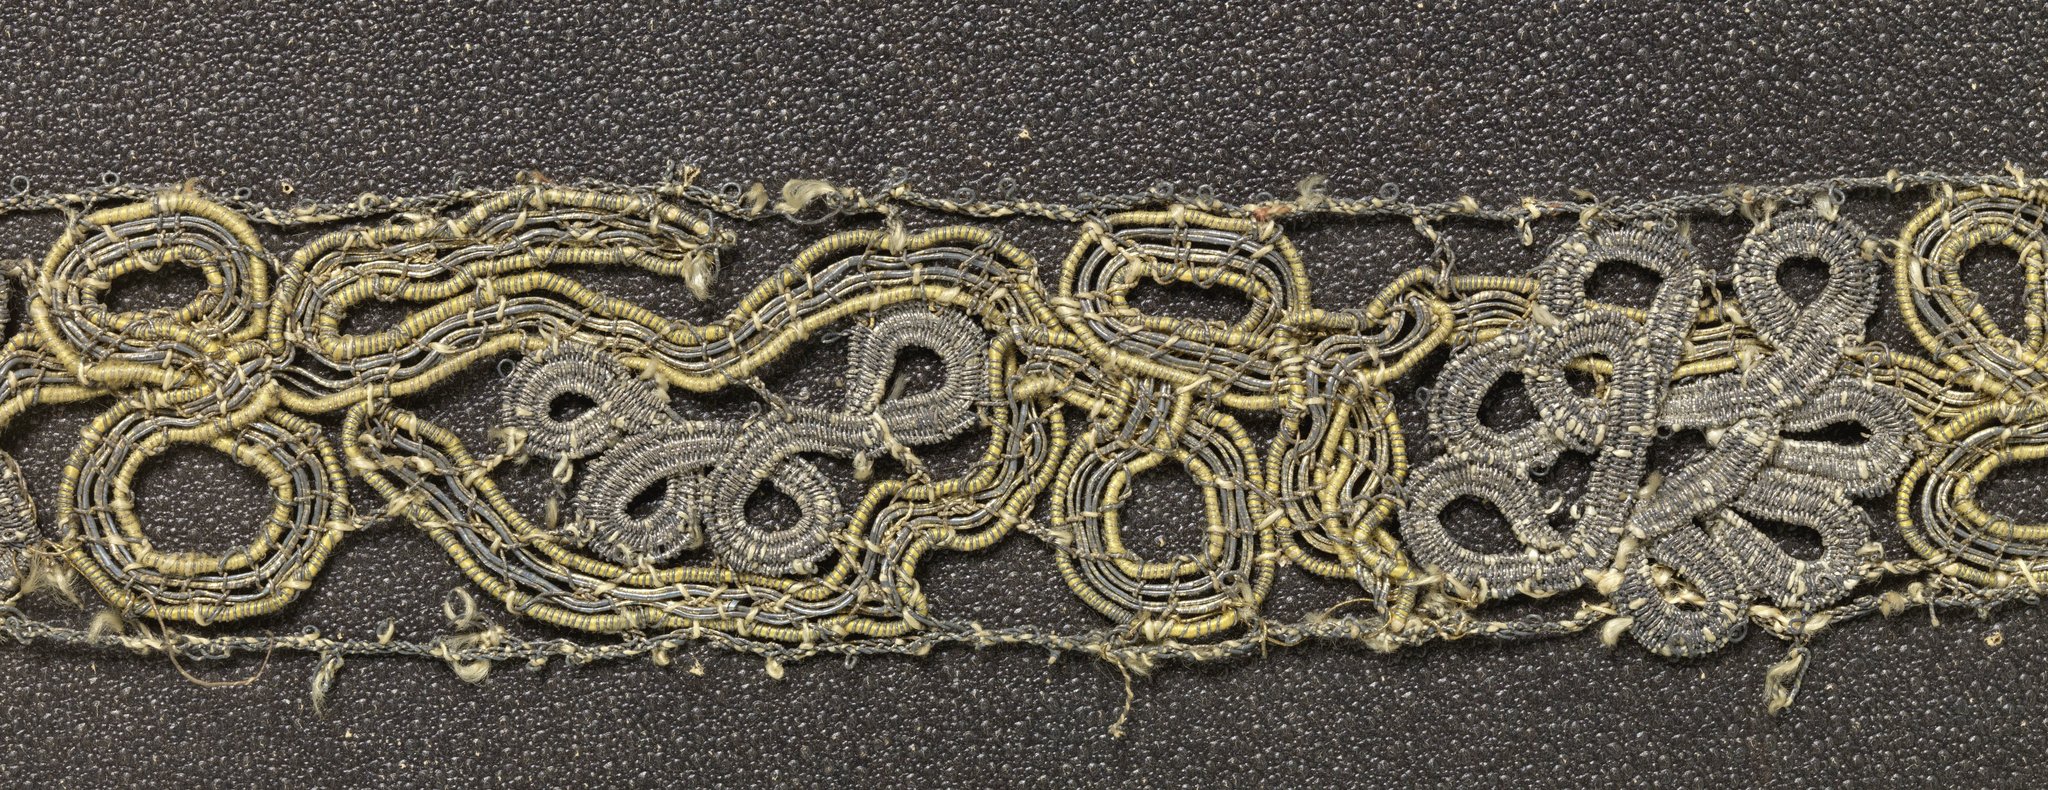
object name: braid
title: Strook van goudkant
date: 1700-1800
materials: gold thread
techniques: gold lace